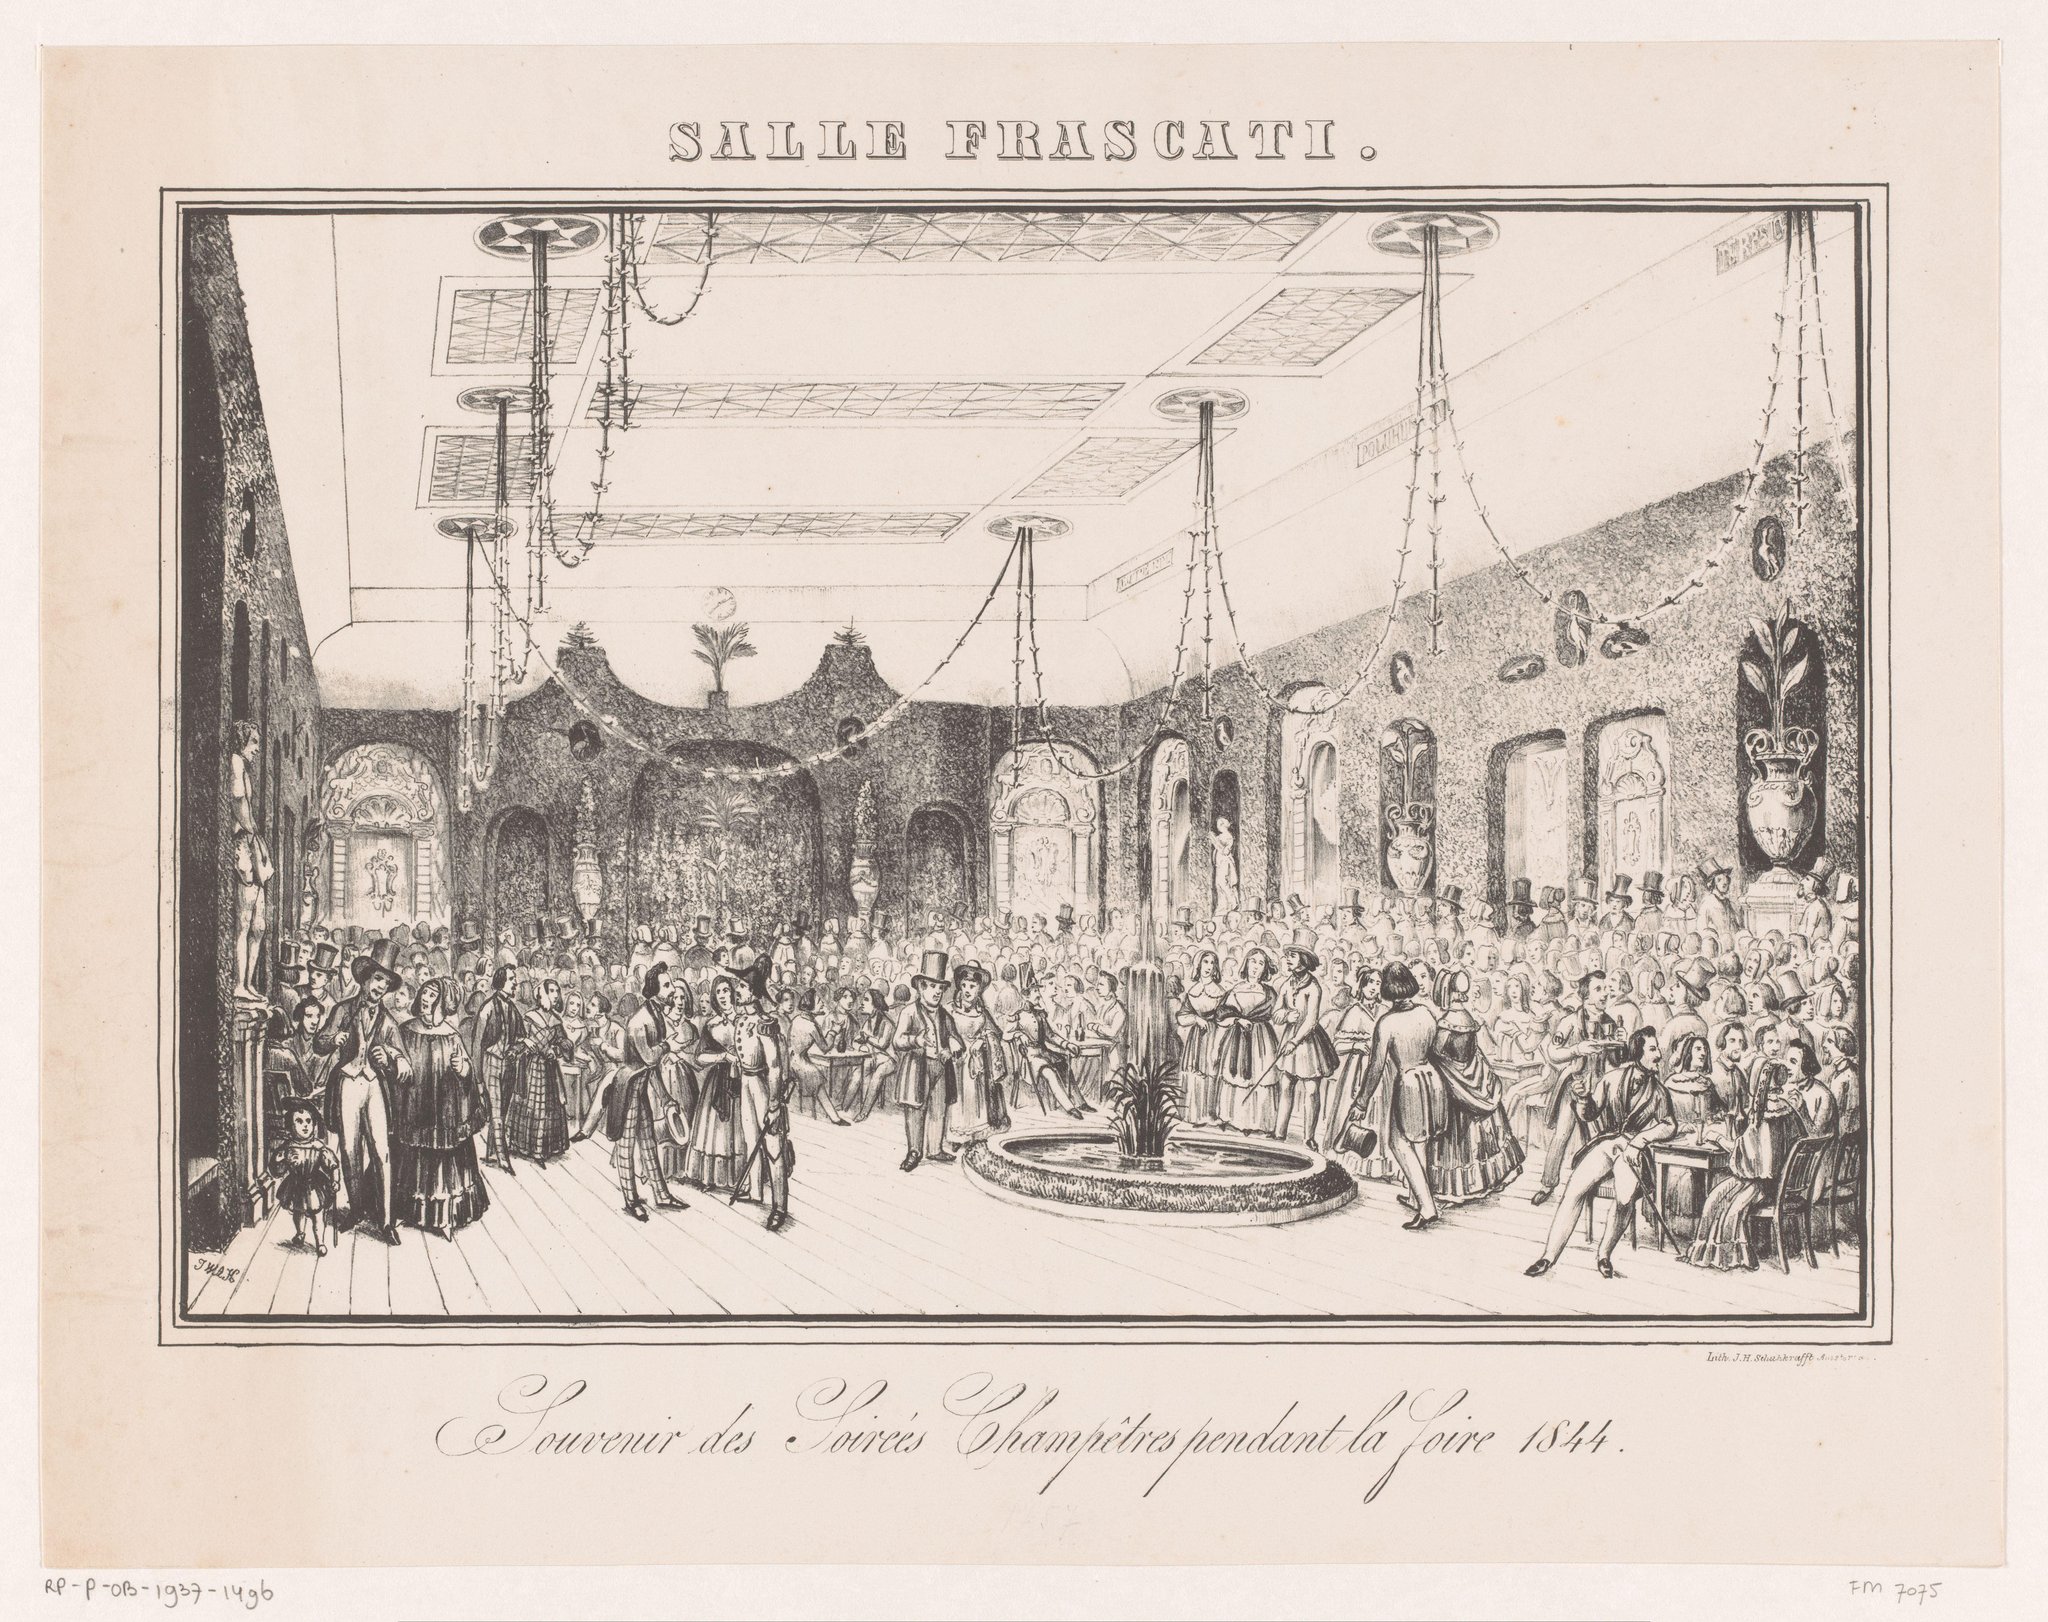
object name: print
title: Interieur van Frascati in Amsterdam tijdens een soiree in 1844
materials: paper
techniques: lithograph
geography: amsterdam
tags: reception, cocktail party, festivities (+ wreath, garland ~ festive activities), fountain (indoors)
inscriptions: collector's mark: Lugt 2228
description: De zaal is gevuld met mannen en vrouwen. In het midden een fontein. Aan het plafond hangen slingers.